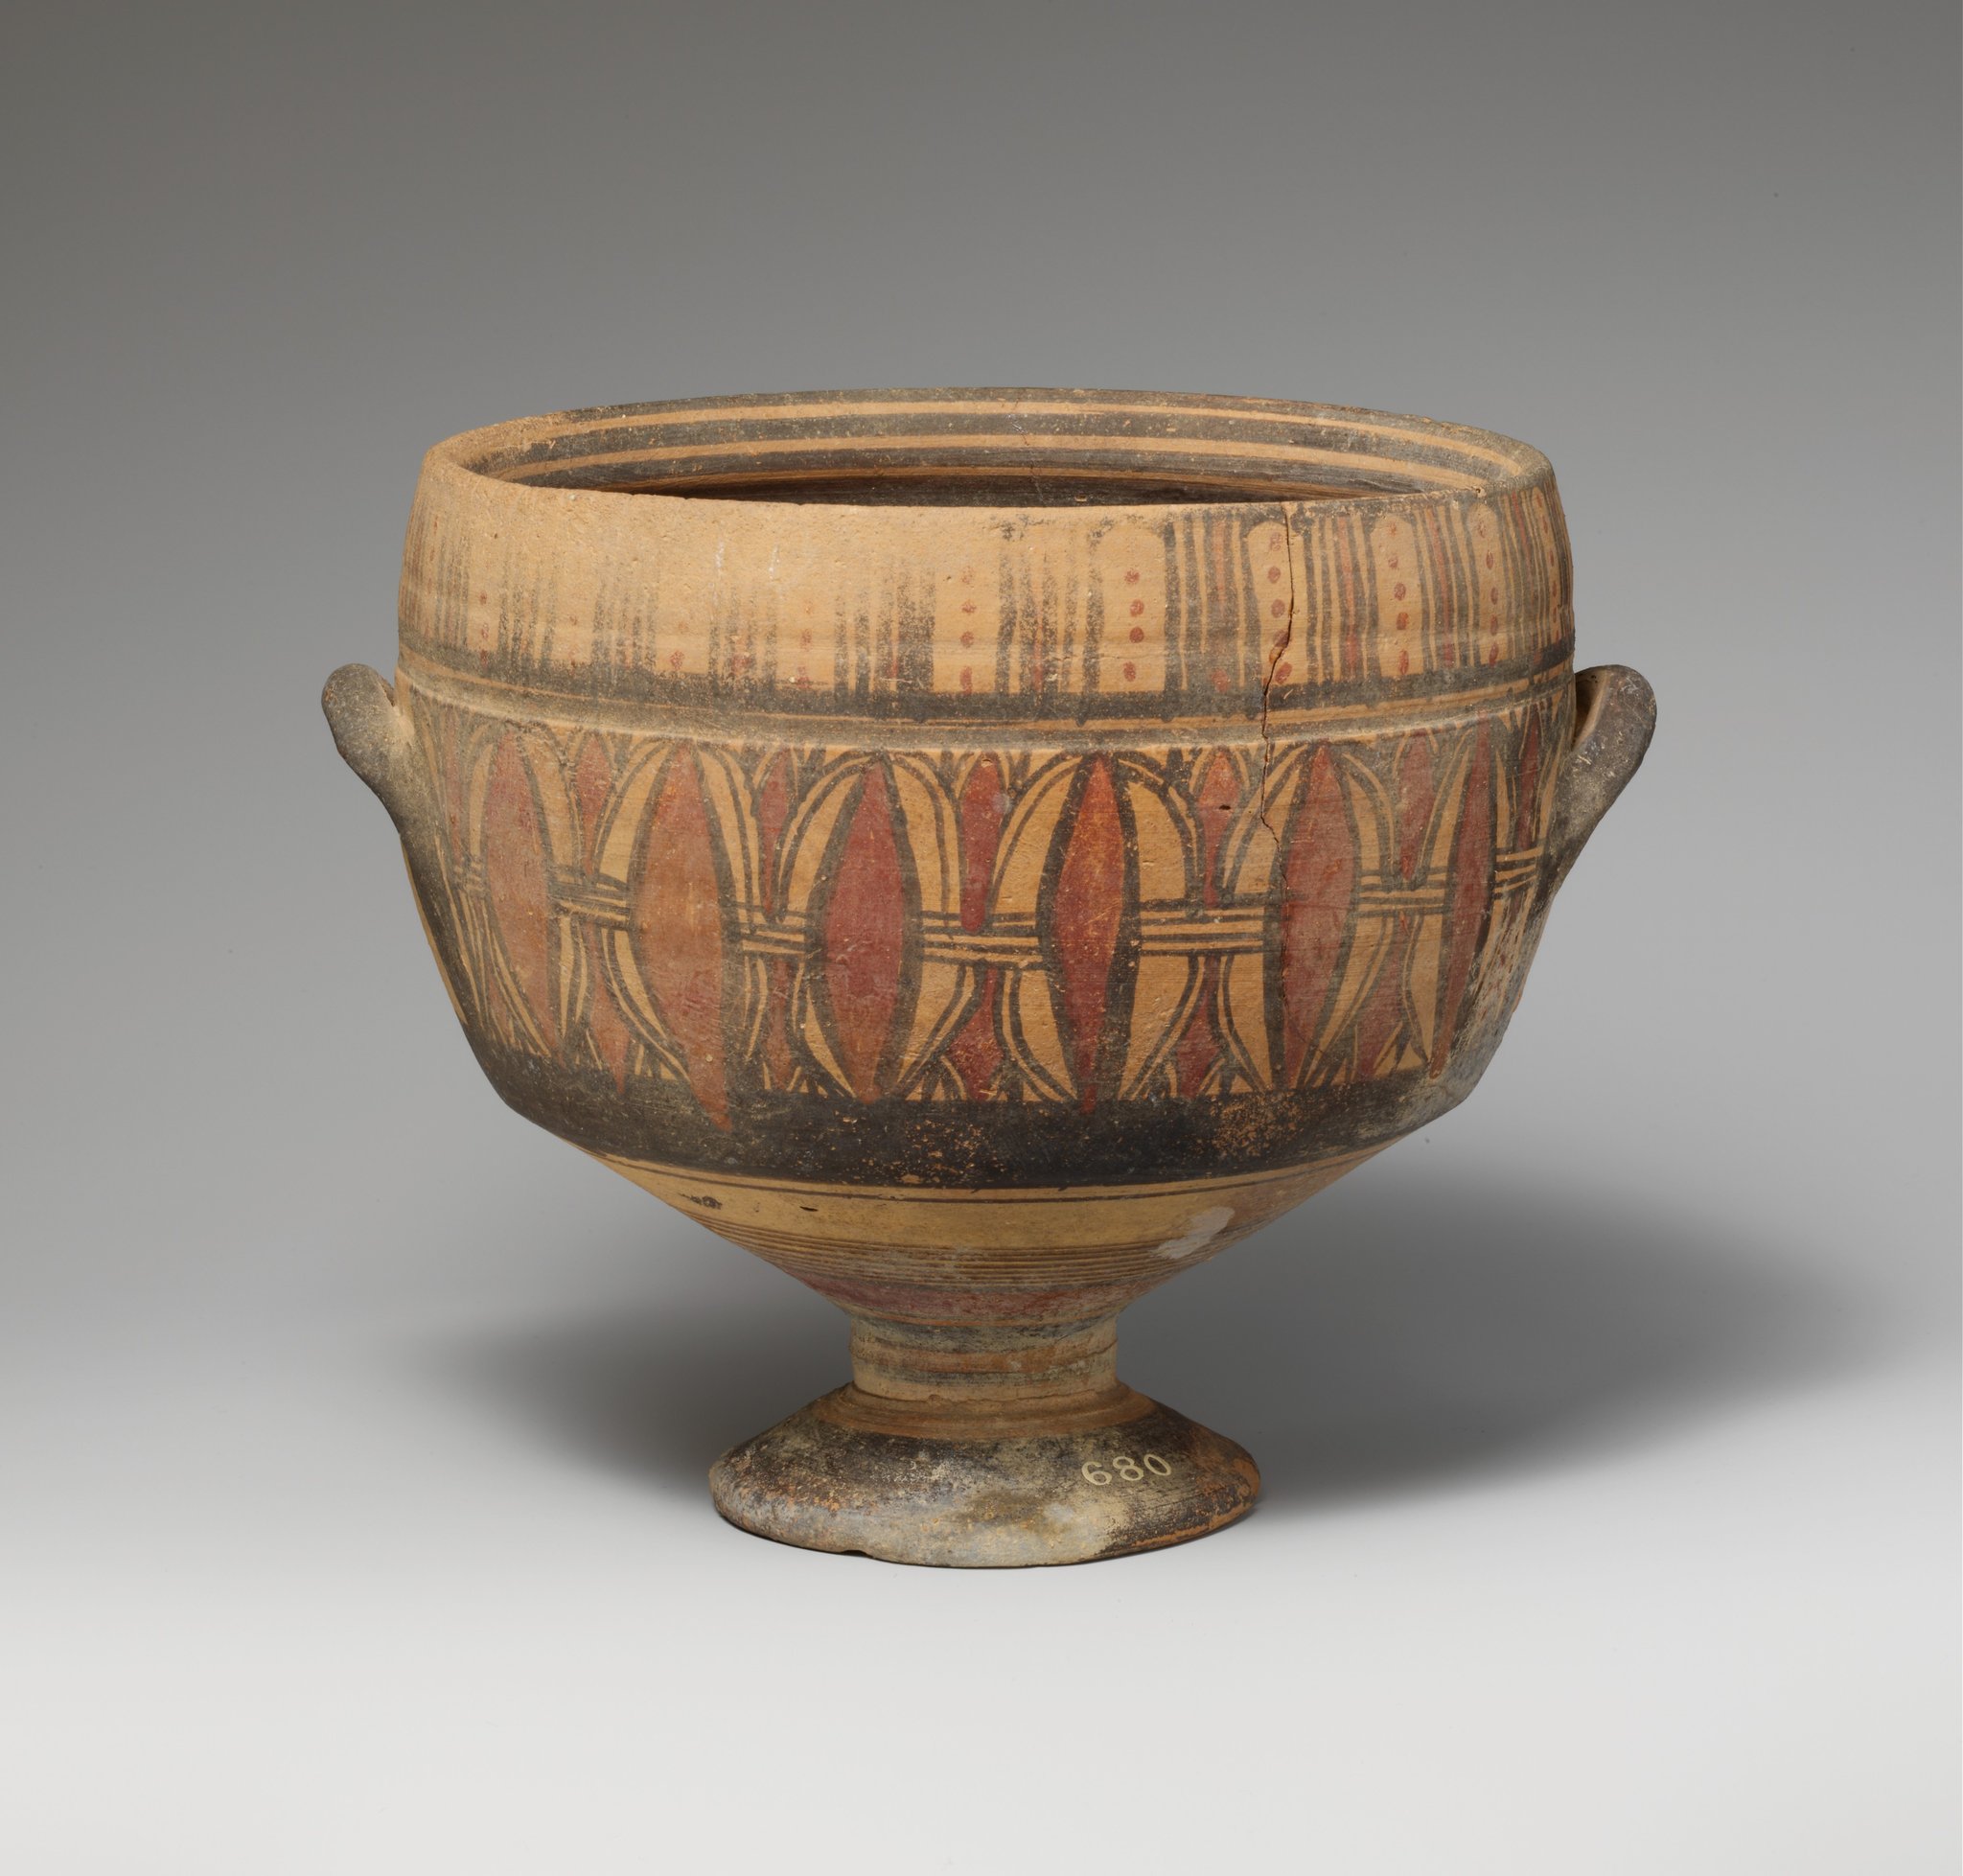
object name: kylix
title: Terracotta kylix (cup)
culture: cypriot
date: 600-480 BCE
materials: terracotta